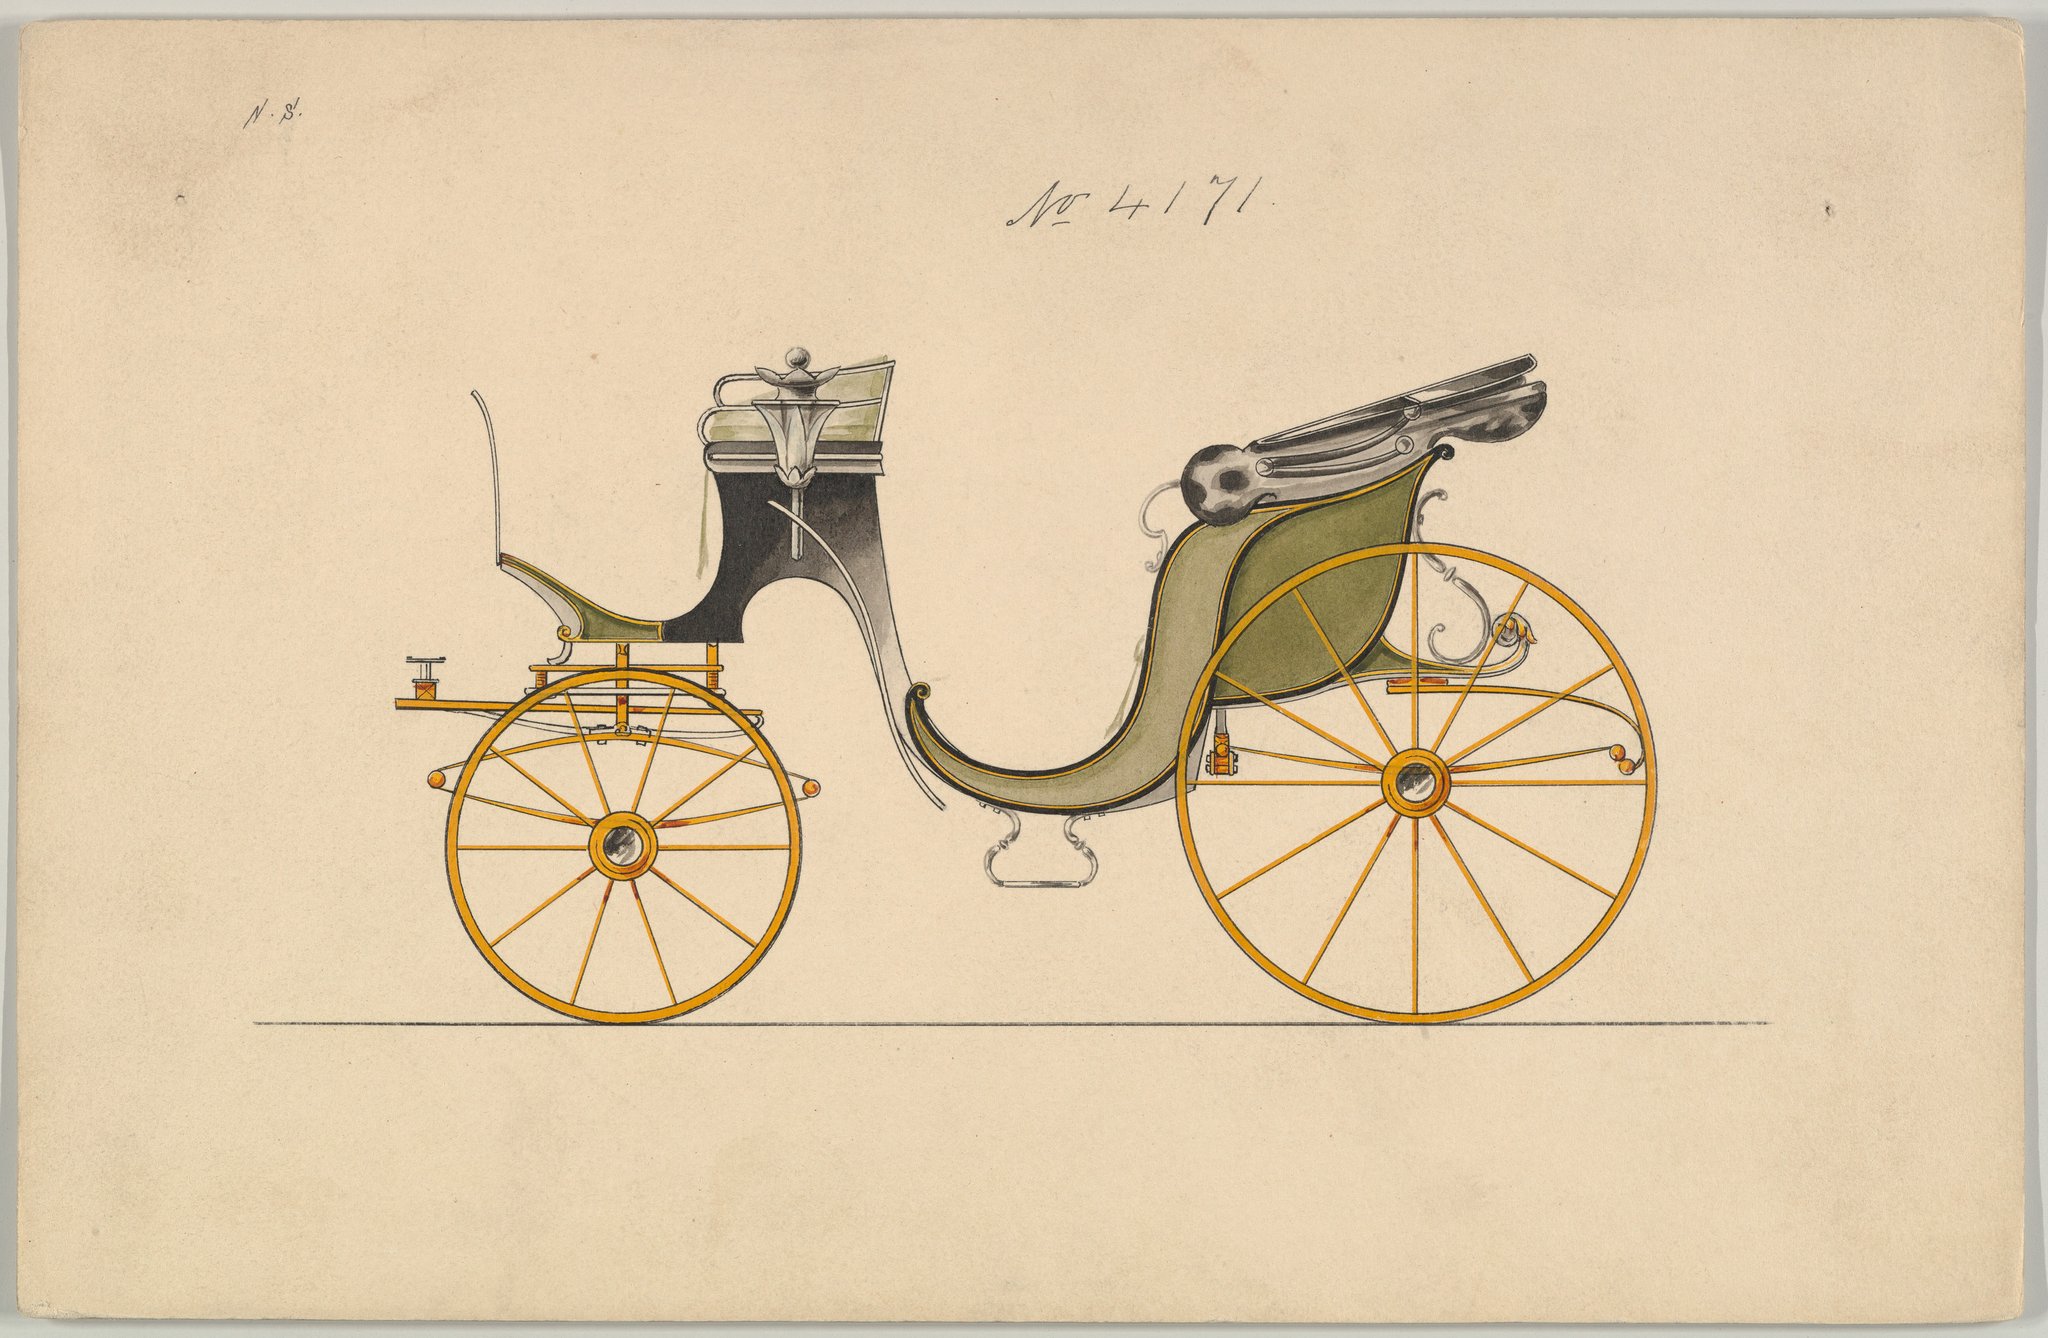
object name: drawing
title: Design for Cabriolet or Victoria, no. 4171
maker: brewster & co.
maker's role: manufacturer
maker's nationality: american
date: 1892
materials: gouache, ink, watercolor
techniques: pen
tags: carriages